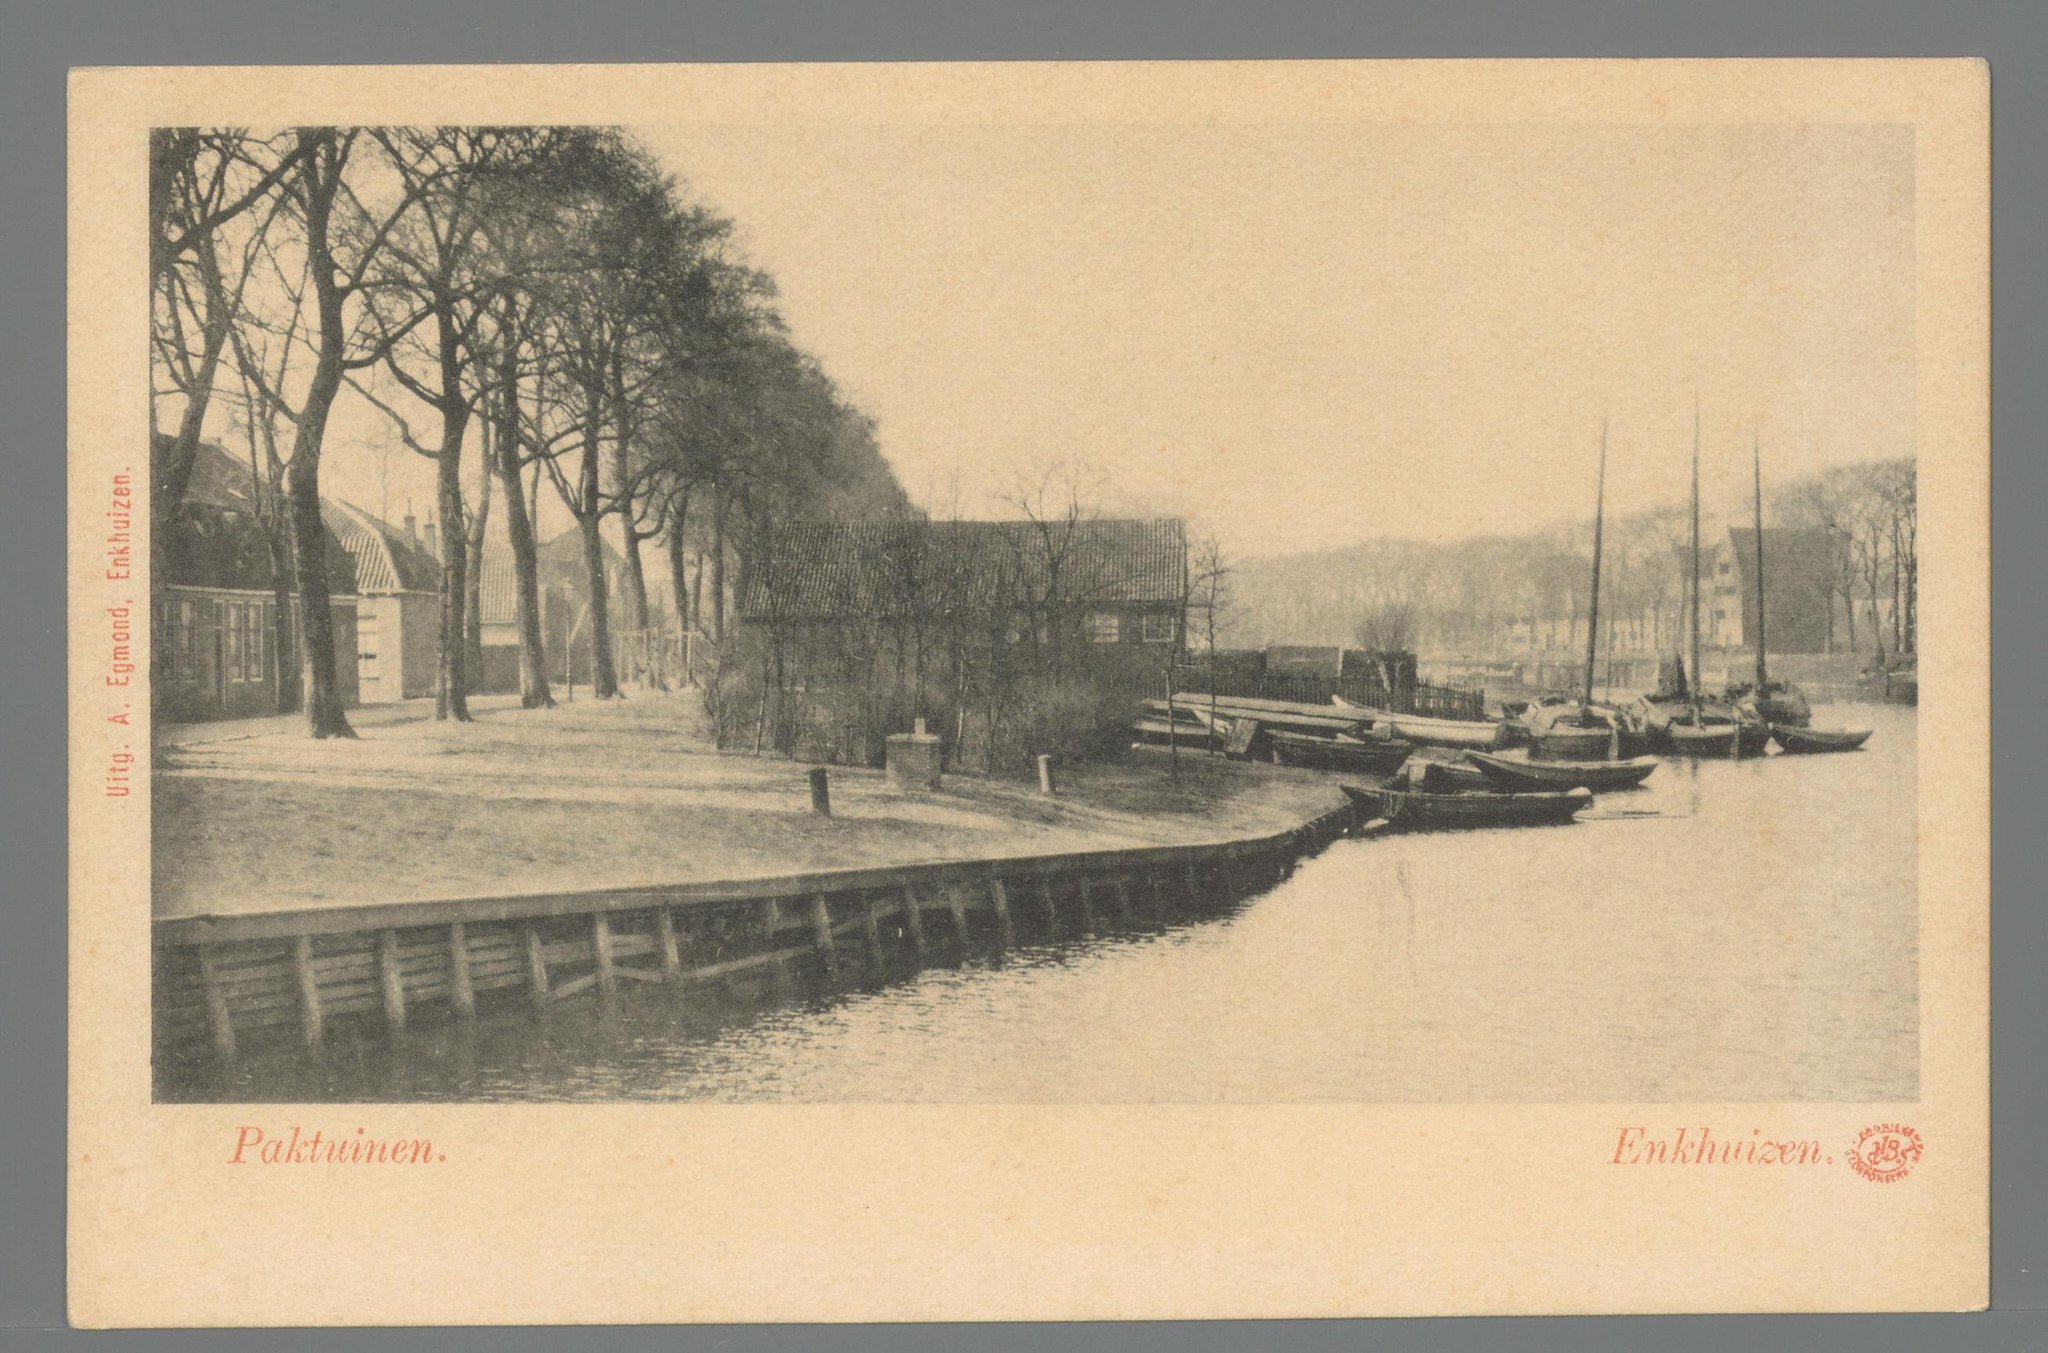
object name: ansichtkaart, prentbriefkaart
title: Paktuinen. Enkhuizen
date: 1892-1905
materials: cardboard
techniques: photograph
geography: amsterdam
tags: city-view, and landscape with man-made constructions, sailing-ship, sailing-boat, enkhuizen